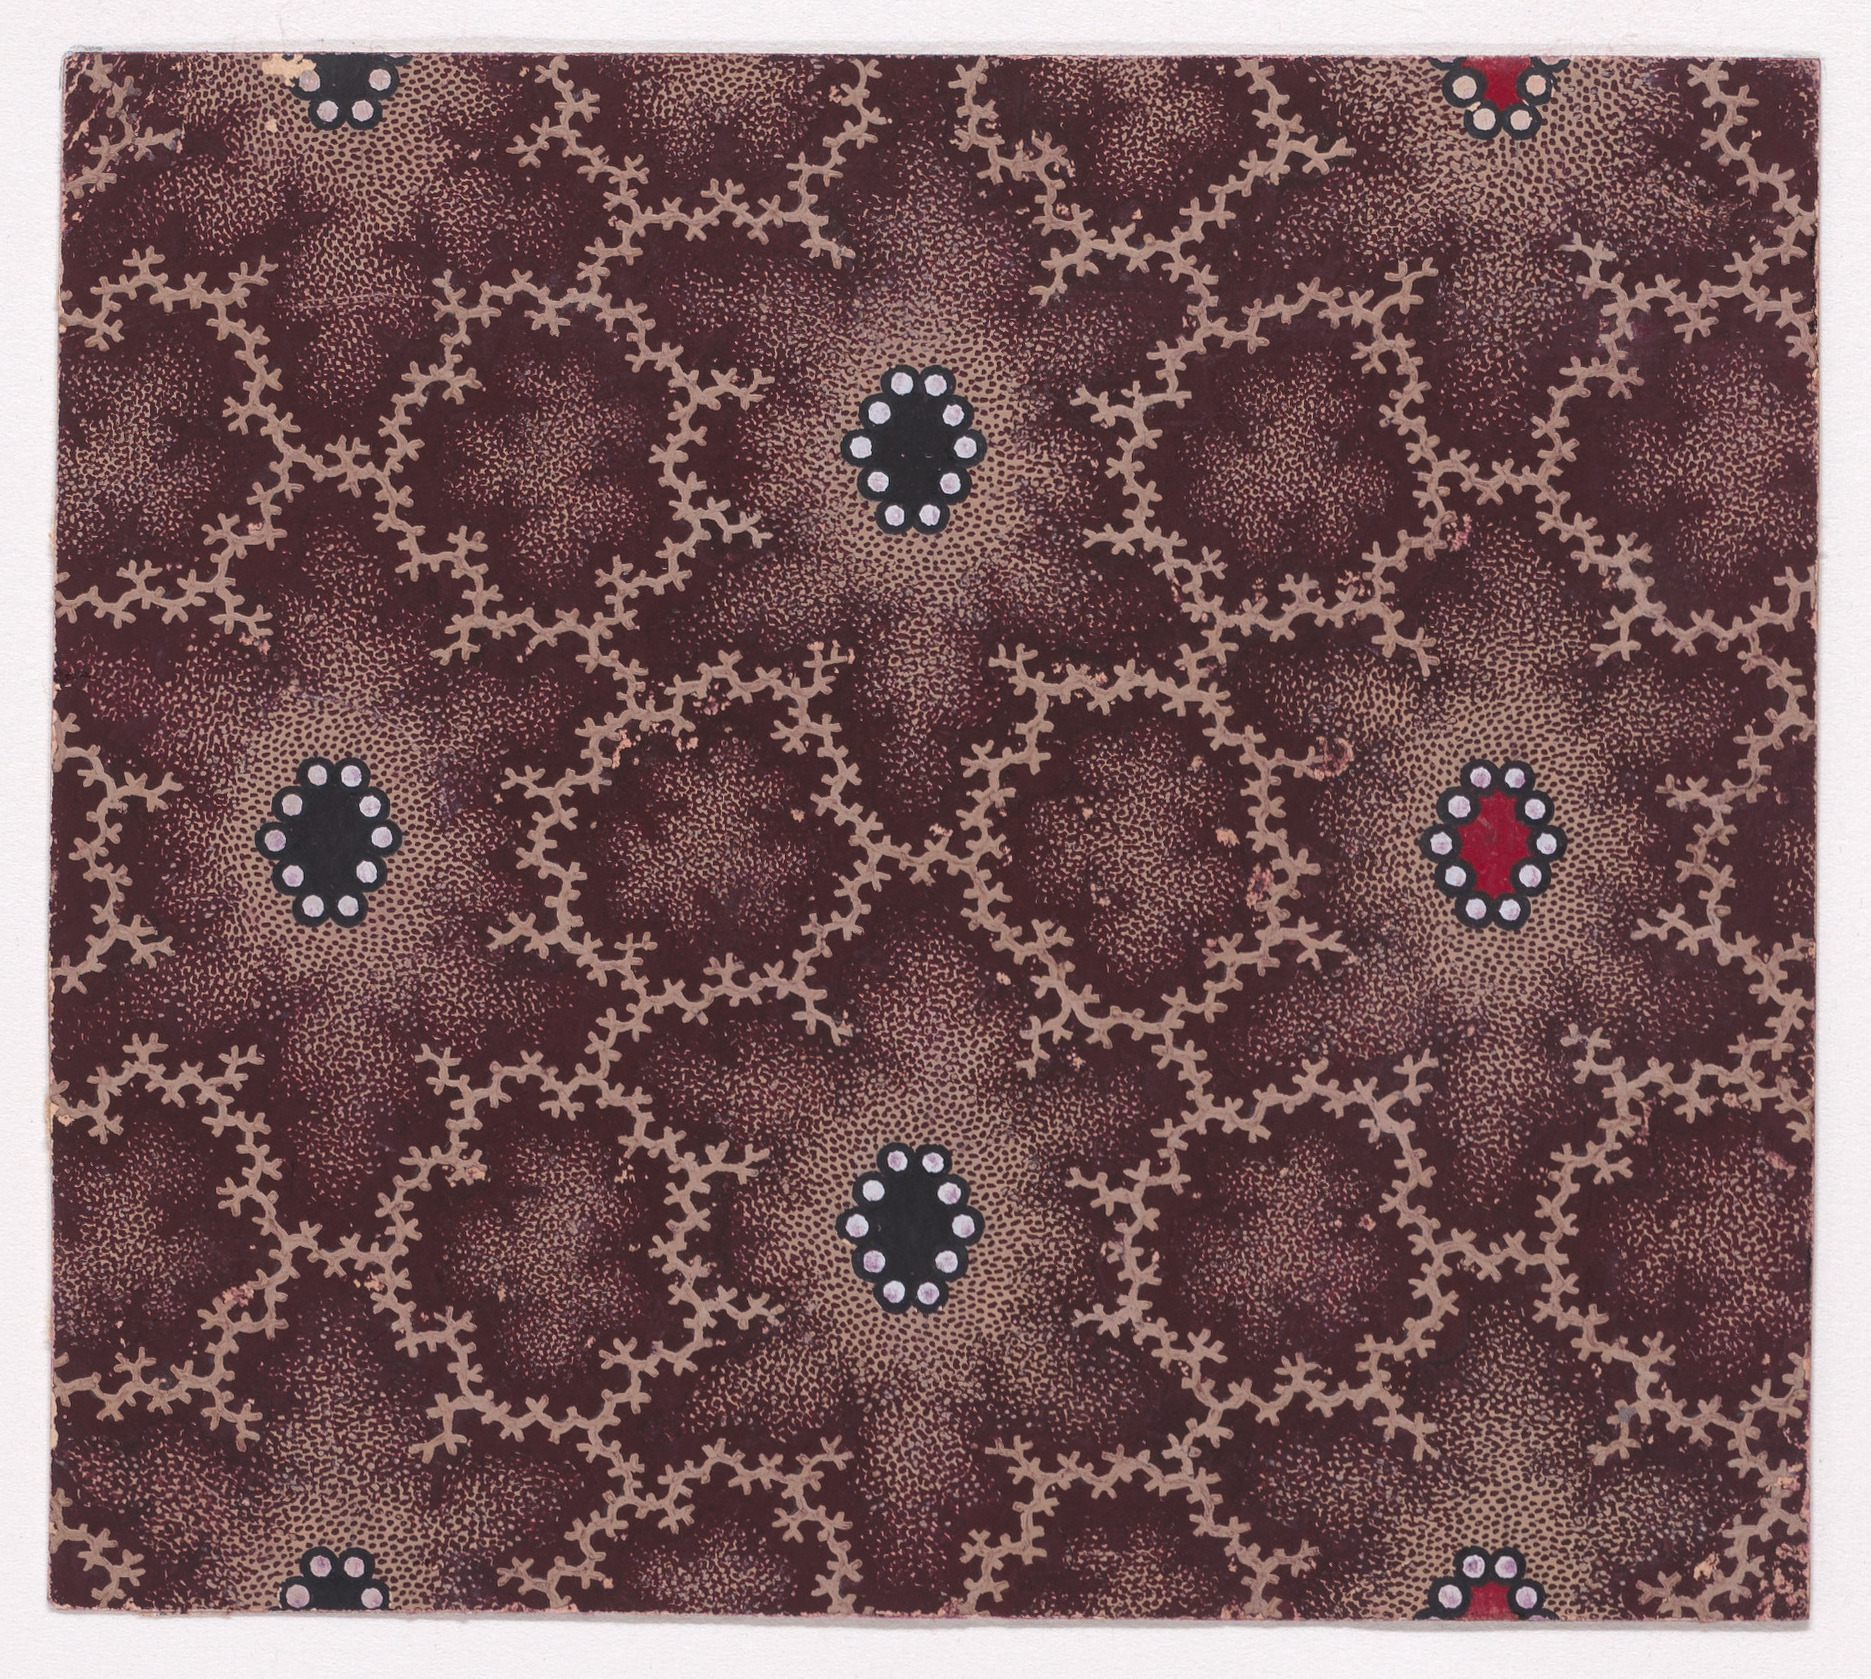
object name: drawing ornament architecture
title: Textile Design with Alternating Vertical Rows of Lozenges and Pearls Framed by Interlacing Garlands of Branches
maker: anonymous, alsatian, 19th century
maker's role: artist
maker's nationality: alsatian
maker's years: 1800-1900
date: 1840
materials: gouache